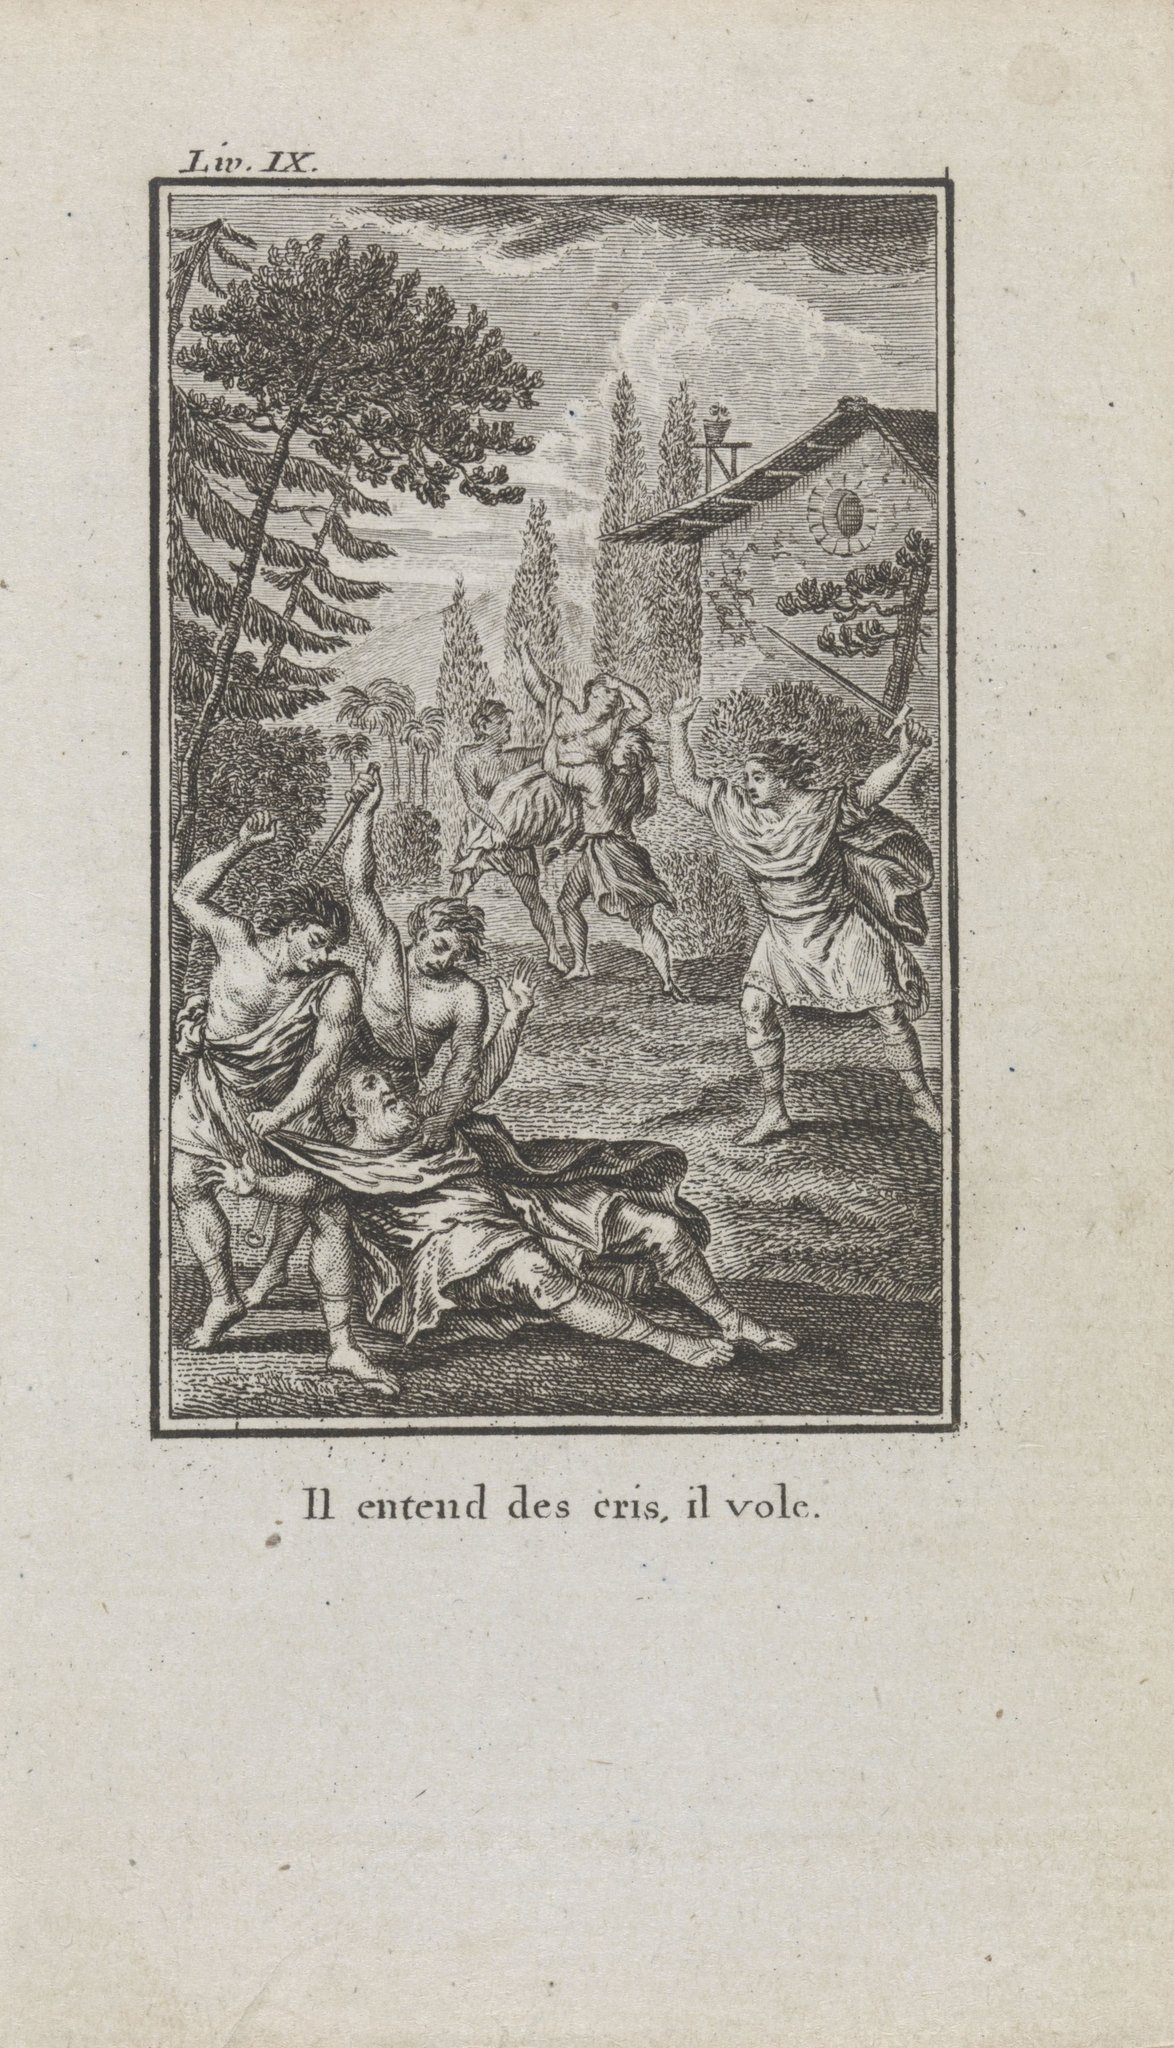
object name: print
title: Numa redt Annna en haar vader van bandieten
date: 1790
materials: paper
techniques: engraving, letterpress printing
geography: liège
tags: robbery, male literary characters (with name)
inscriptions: collector's mark: Lugt 2228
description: Anna en haar vader worden overvallen door bandieten. Numa komt hen met getrokken zwaard te hulp gesneld. Met een Frans onderschrift.